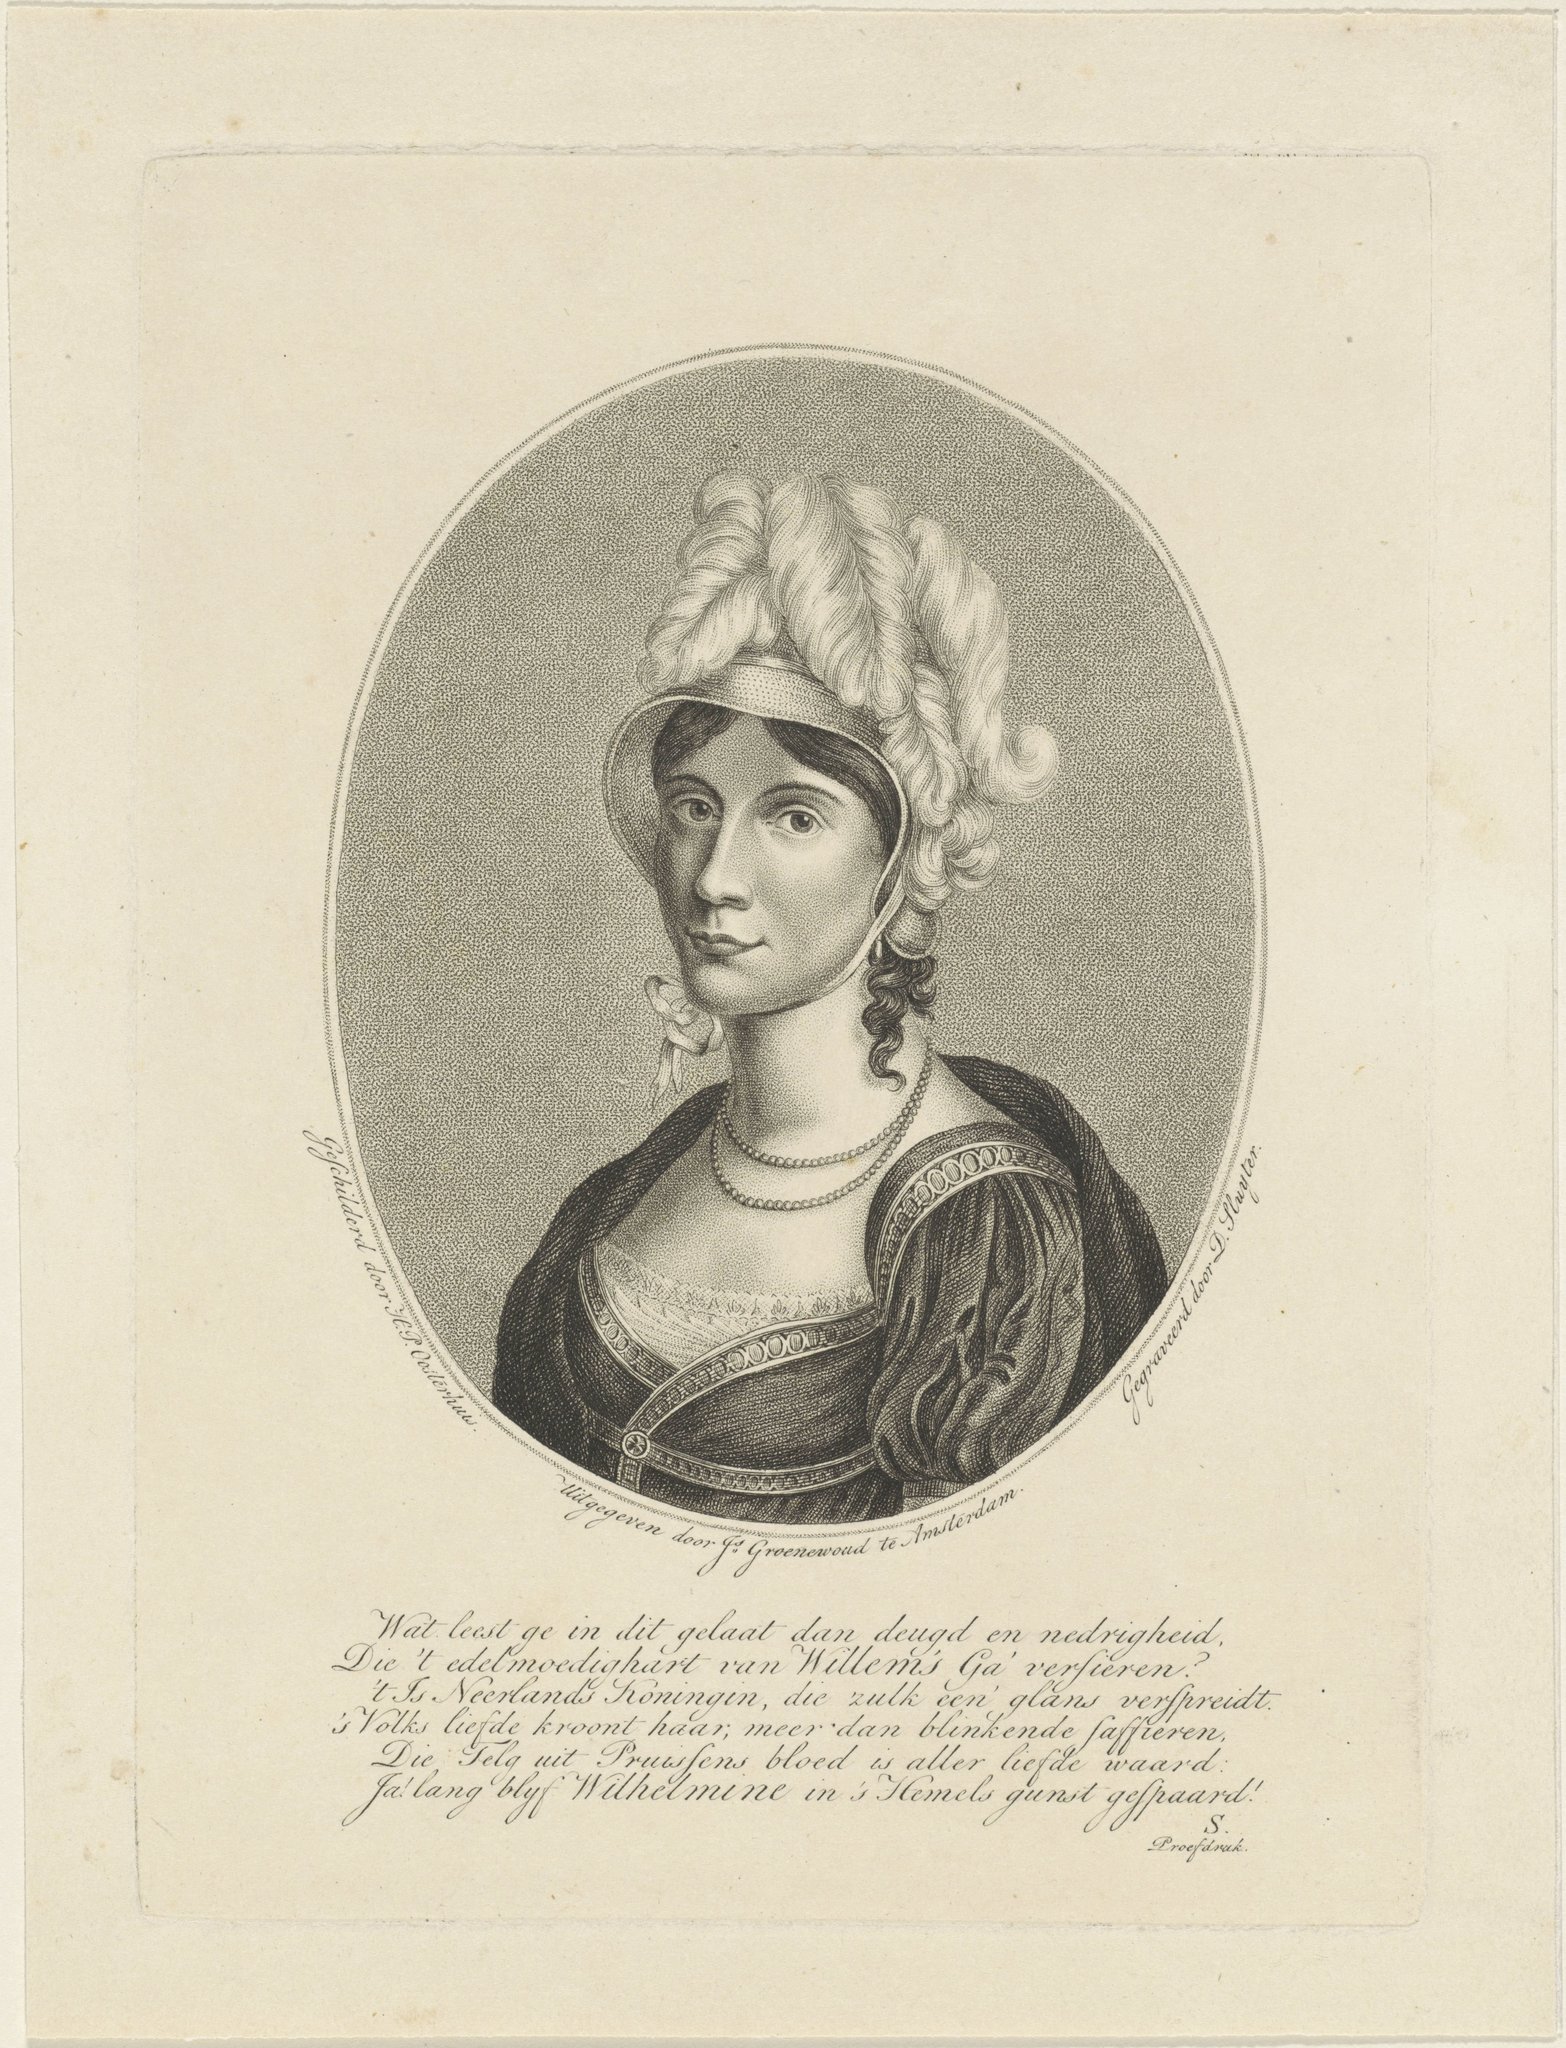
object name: print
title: Portret van Wilhelmina van Pruisen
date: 1815-1819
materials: paper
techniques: engraving, etching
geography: amsterdam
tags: berlin, the hague, wilhelmina frederica louisa (koningin der nederlanden)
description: Portret van Wilhelmina in een ovaal. In de ondermarge zes regels Nederlandse tekst. Rechtsonder 'Proefdruk.'.